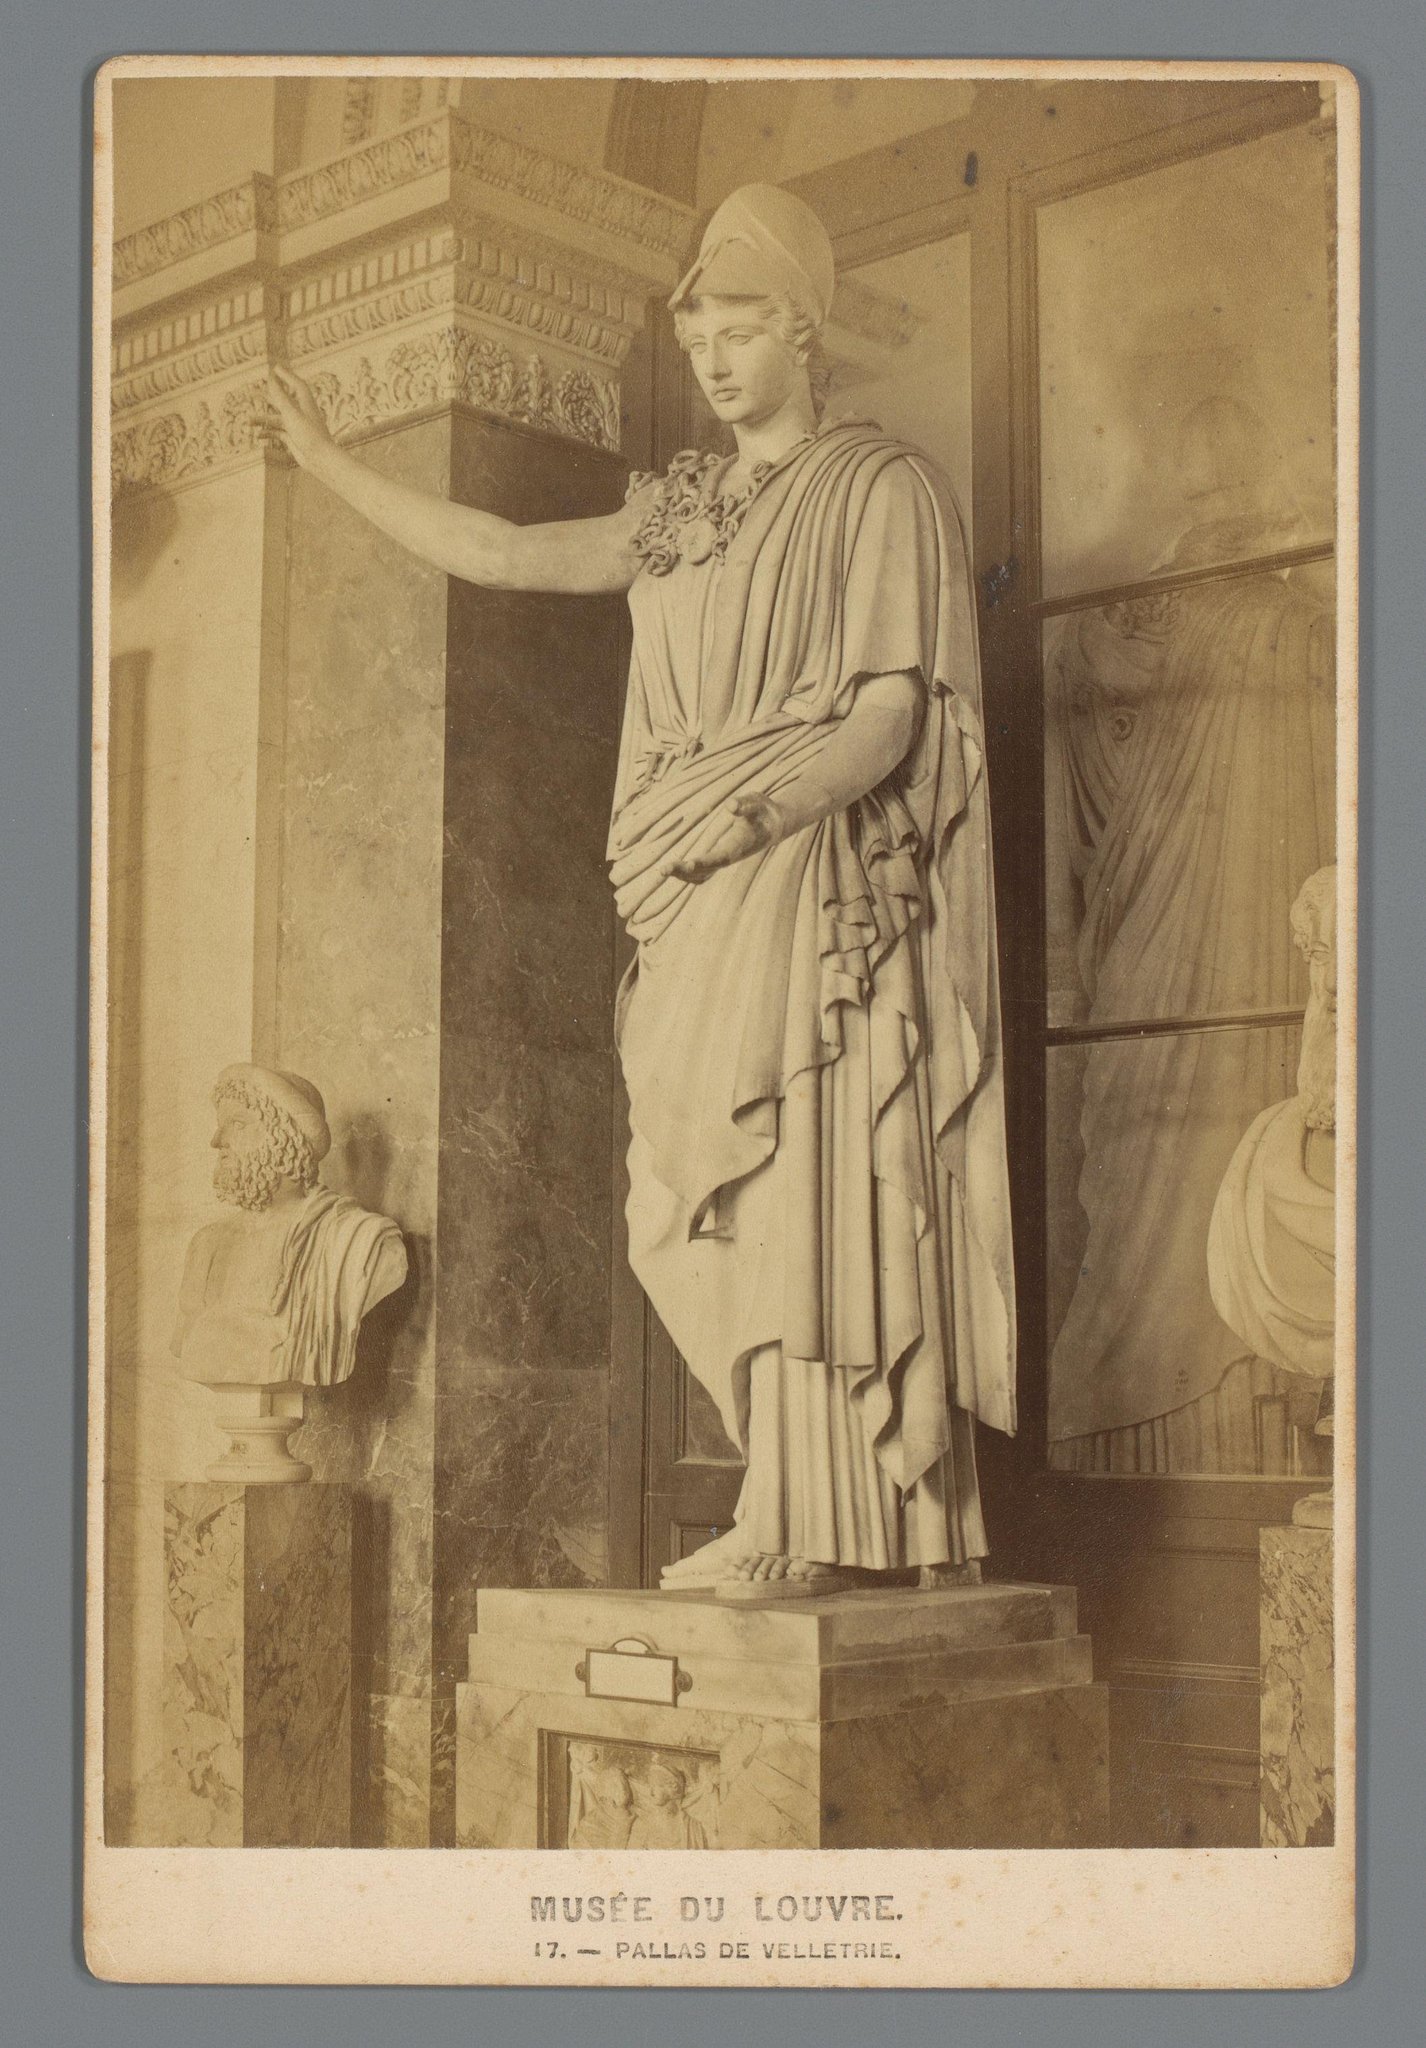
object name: cabinet photograph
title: Pallas de Velletrie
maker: Anonymous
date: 1866-1900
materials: cardboard, paper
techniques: albumen print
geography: paris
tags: sculpture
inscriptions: number: ‘17.’